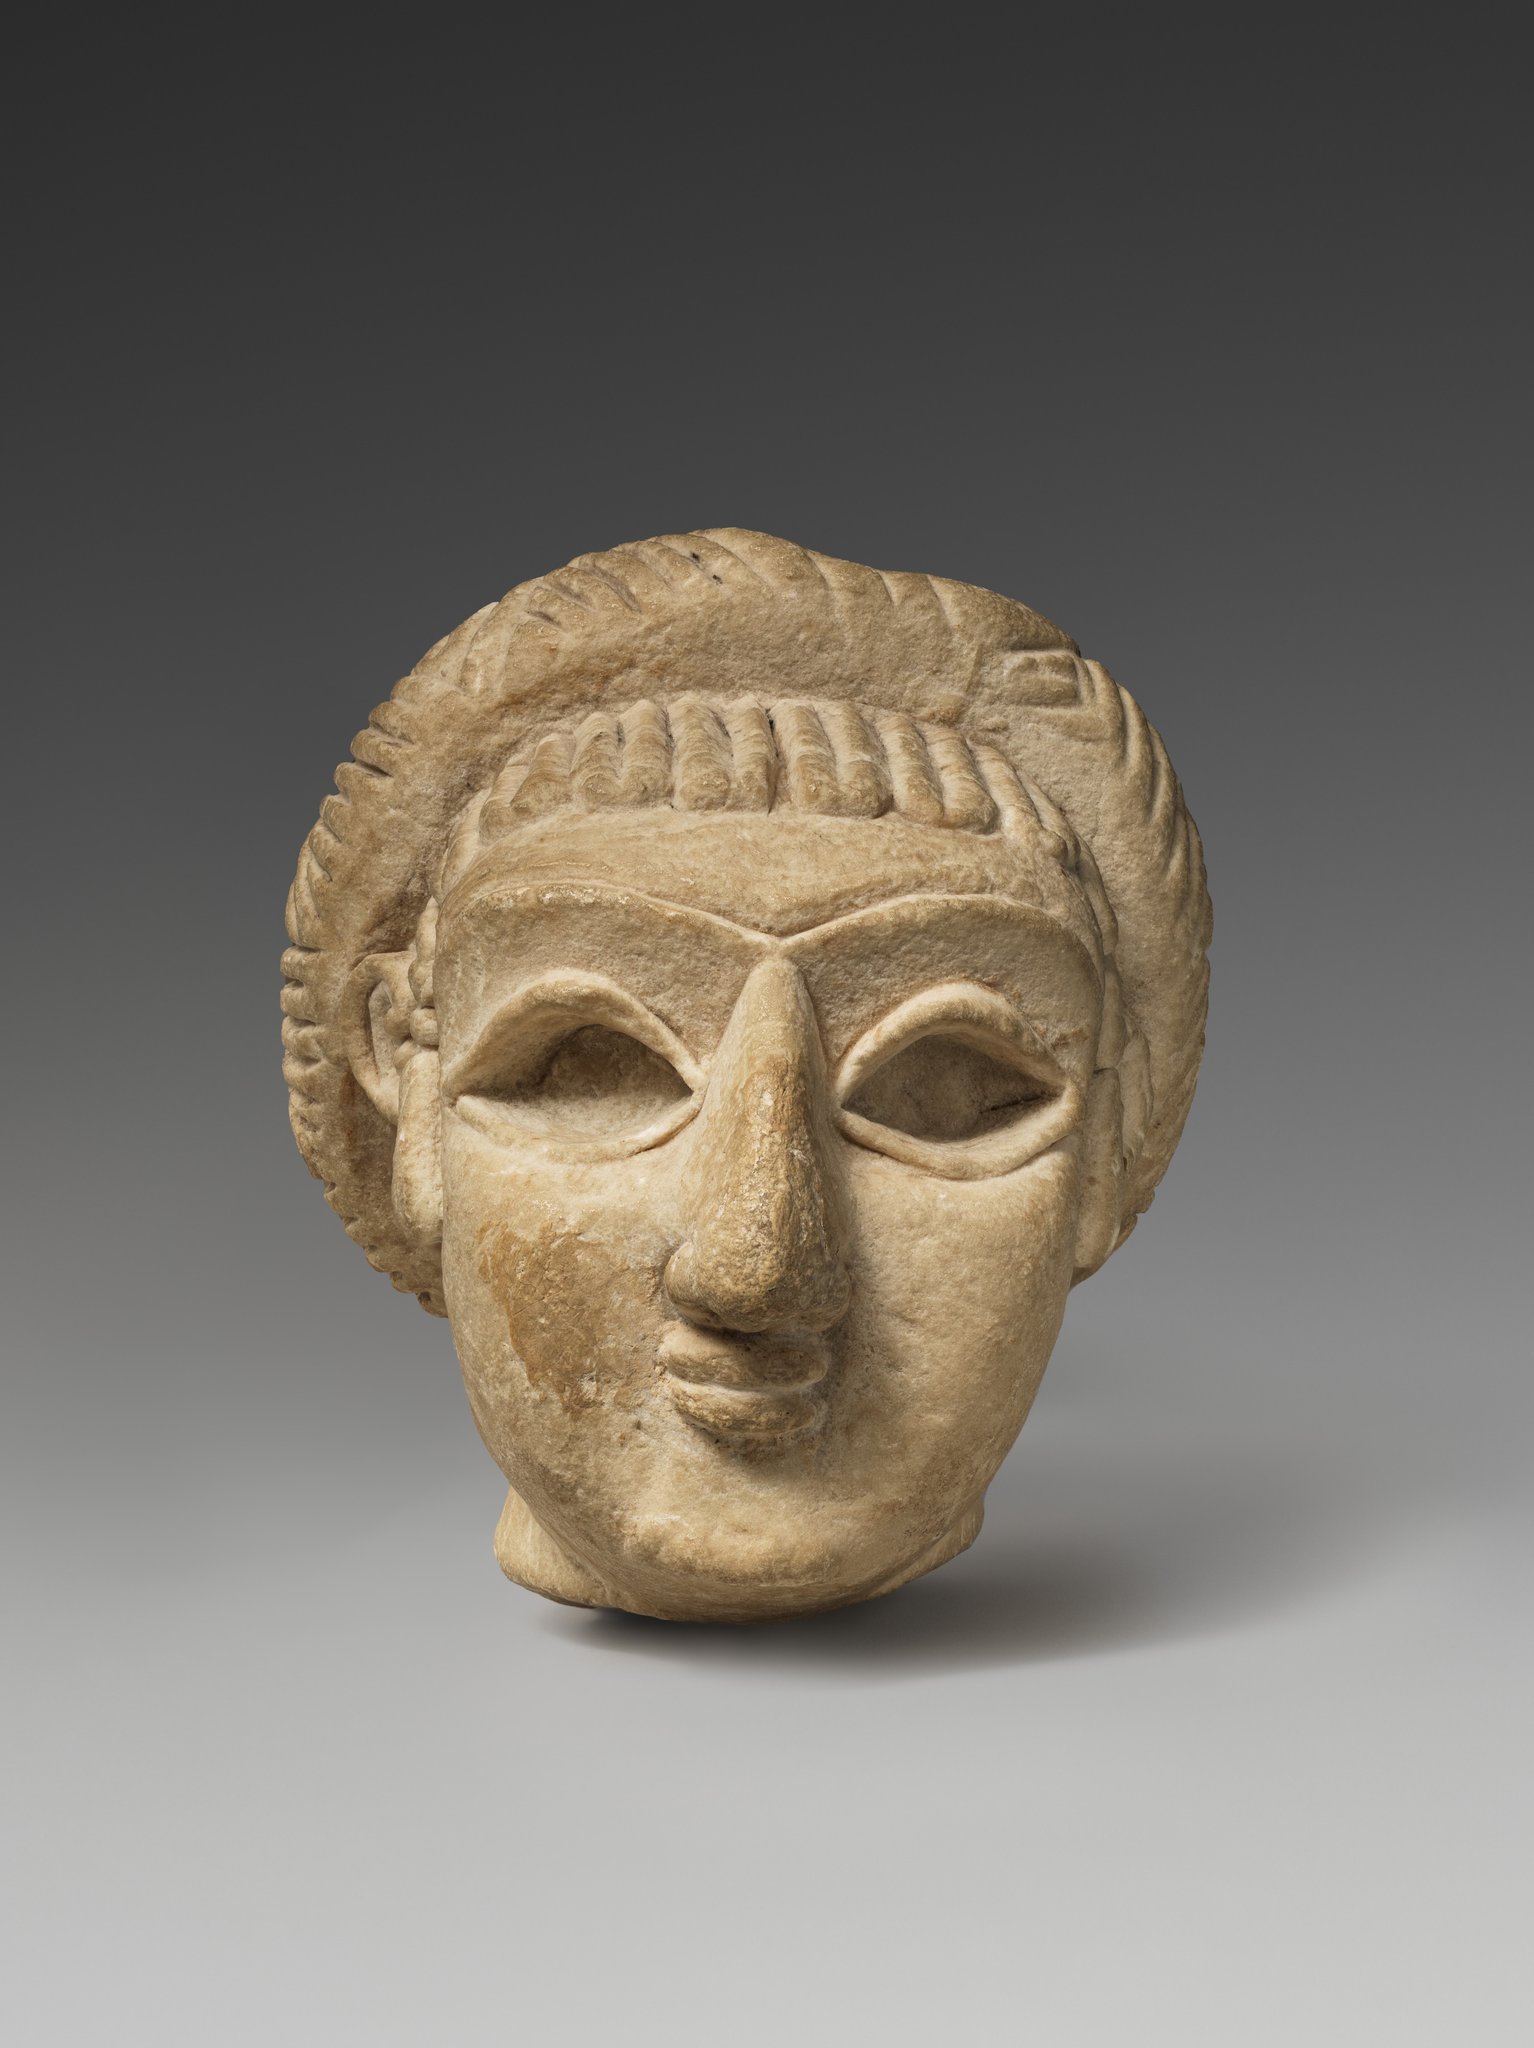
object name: sculpture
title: Female head with elaborate hairstyle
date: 2600-2500 BCE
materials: limestone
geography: mesopotamia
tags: heads,women